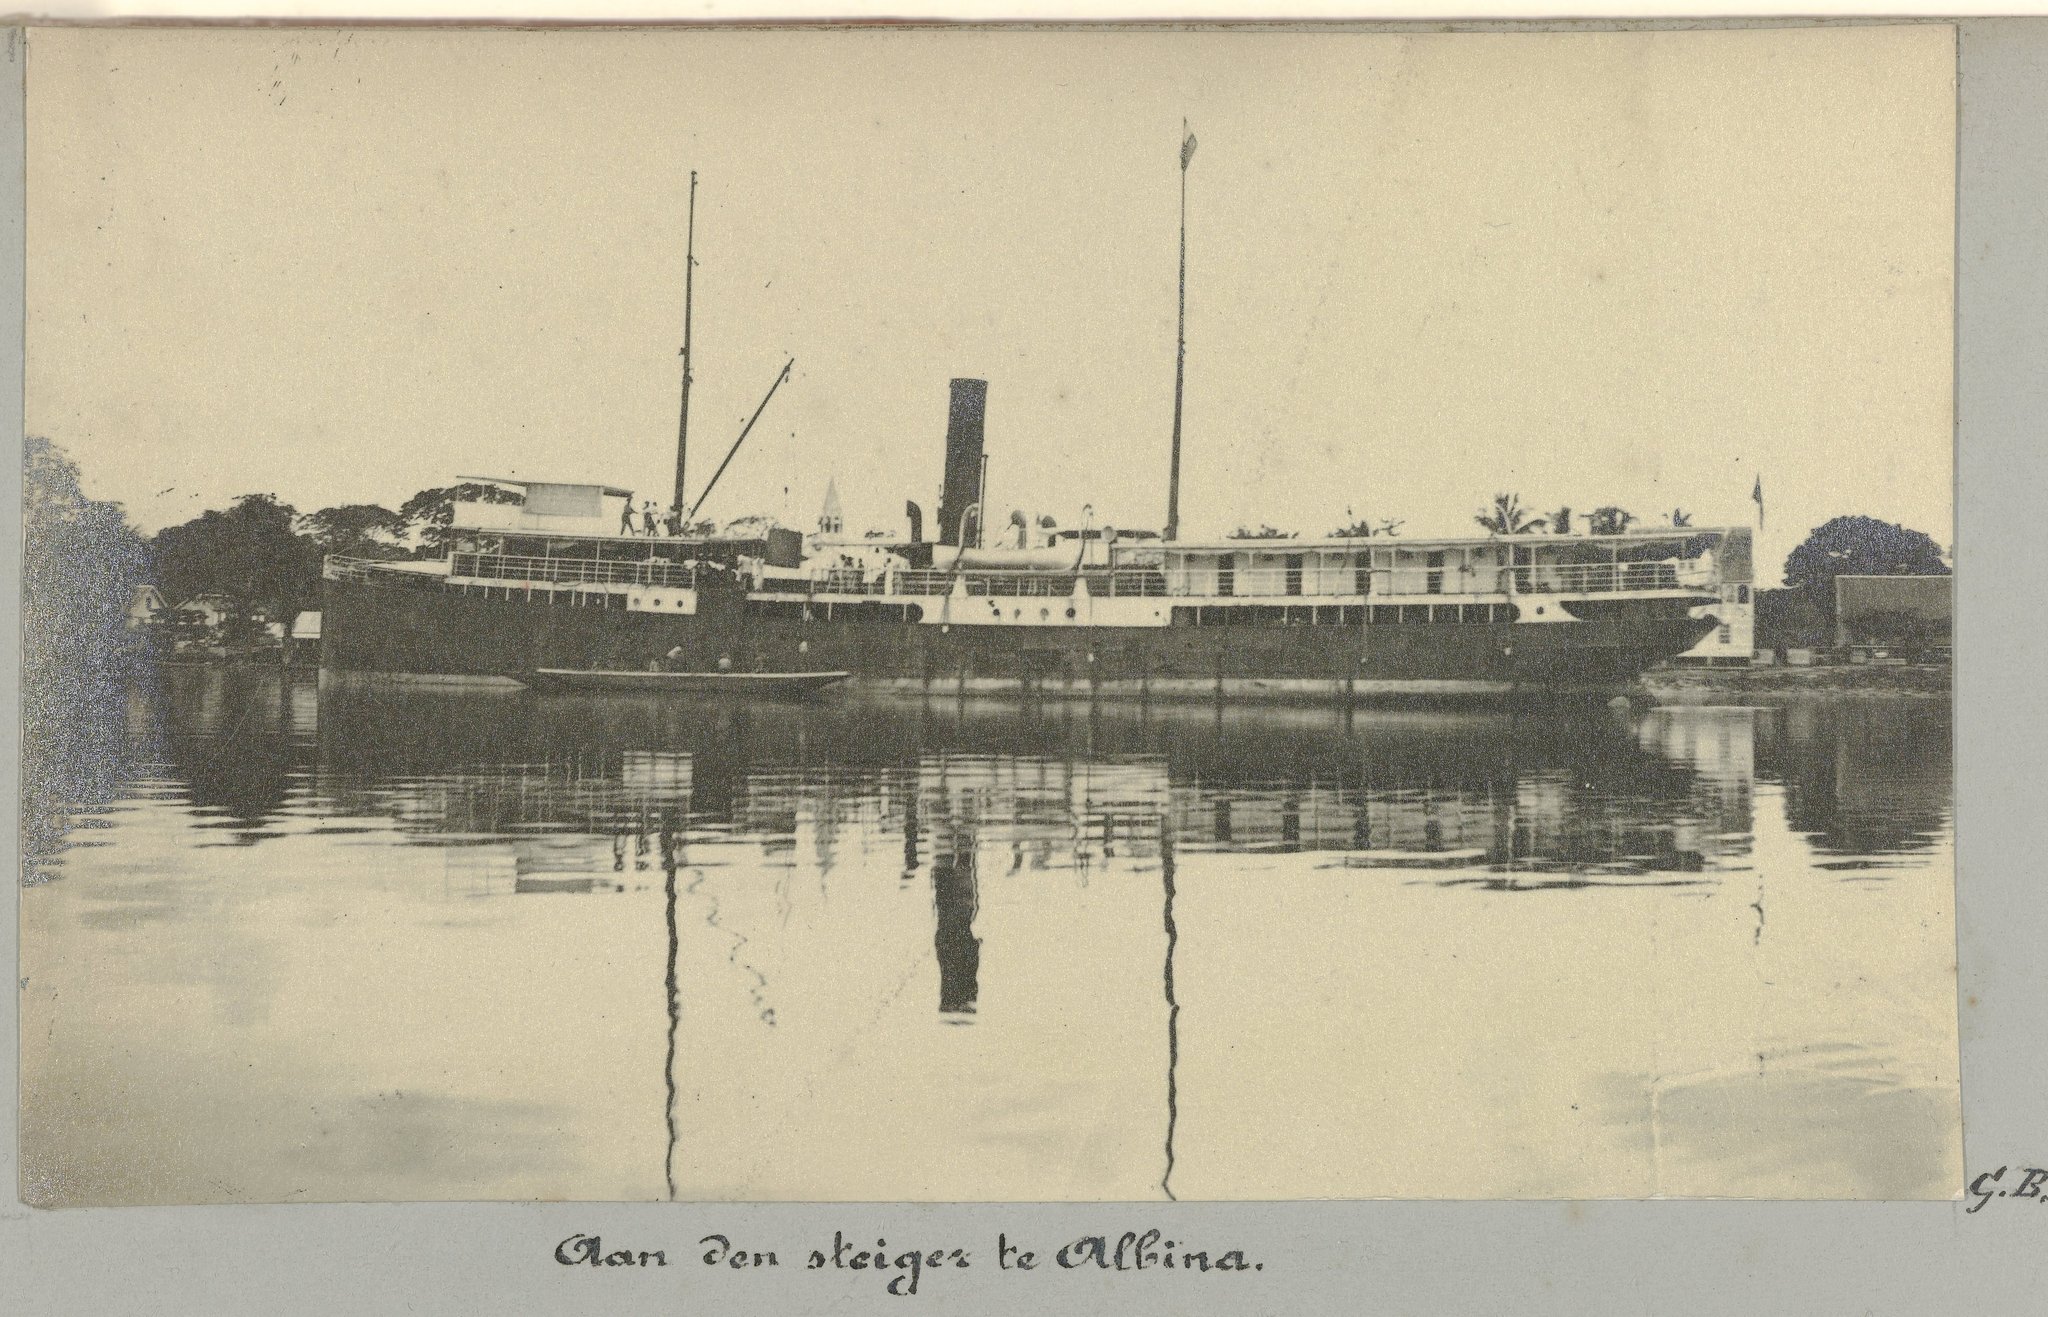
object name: photograph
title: Aan den steiger te Albina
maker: gomez burke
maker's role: fotograaf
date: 1891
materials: photographic support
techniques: gelatin silver print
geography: suriname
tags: suriname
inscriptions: inscription: ‘G.B. / Aan den steiger te Albina.’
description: Rivierschip afgemeerd aan de steiger te Albina. Onderdeel van het fotoalbum Souvenir de Voyage (deel 4), over het leven van de familie Dooyer in en rond de plantage Ma Retraite in Suriname in de jaren 1906-1913.